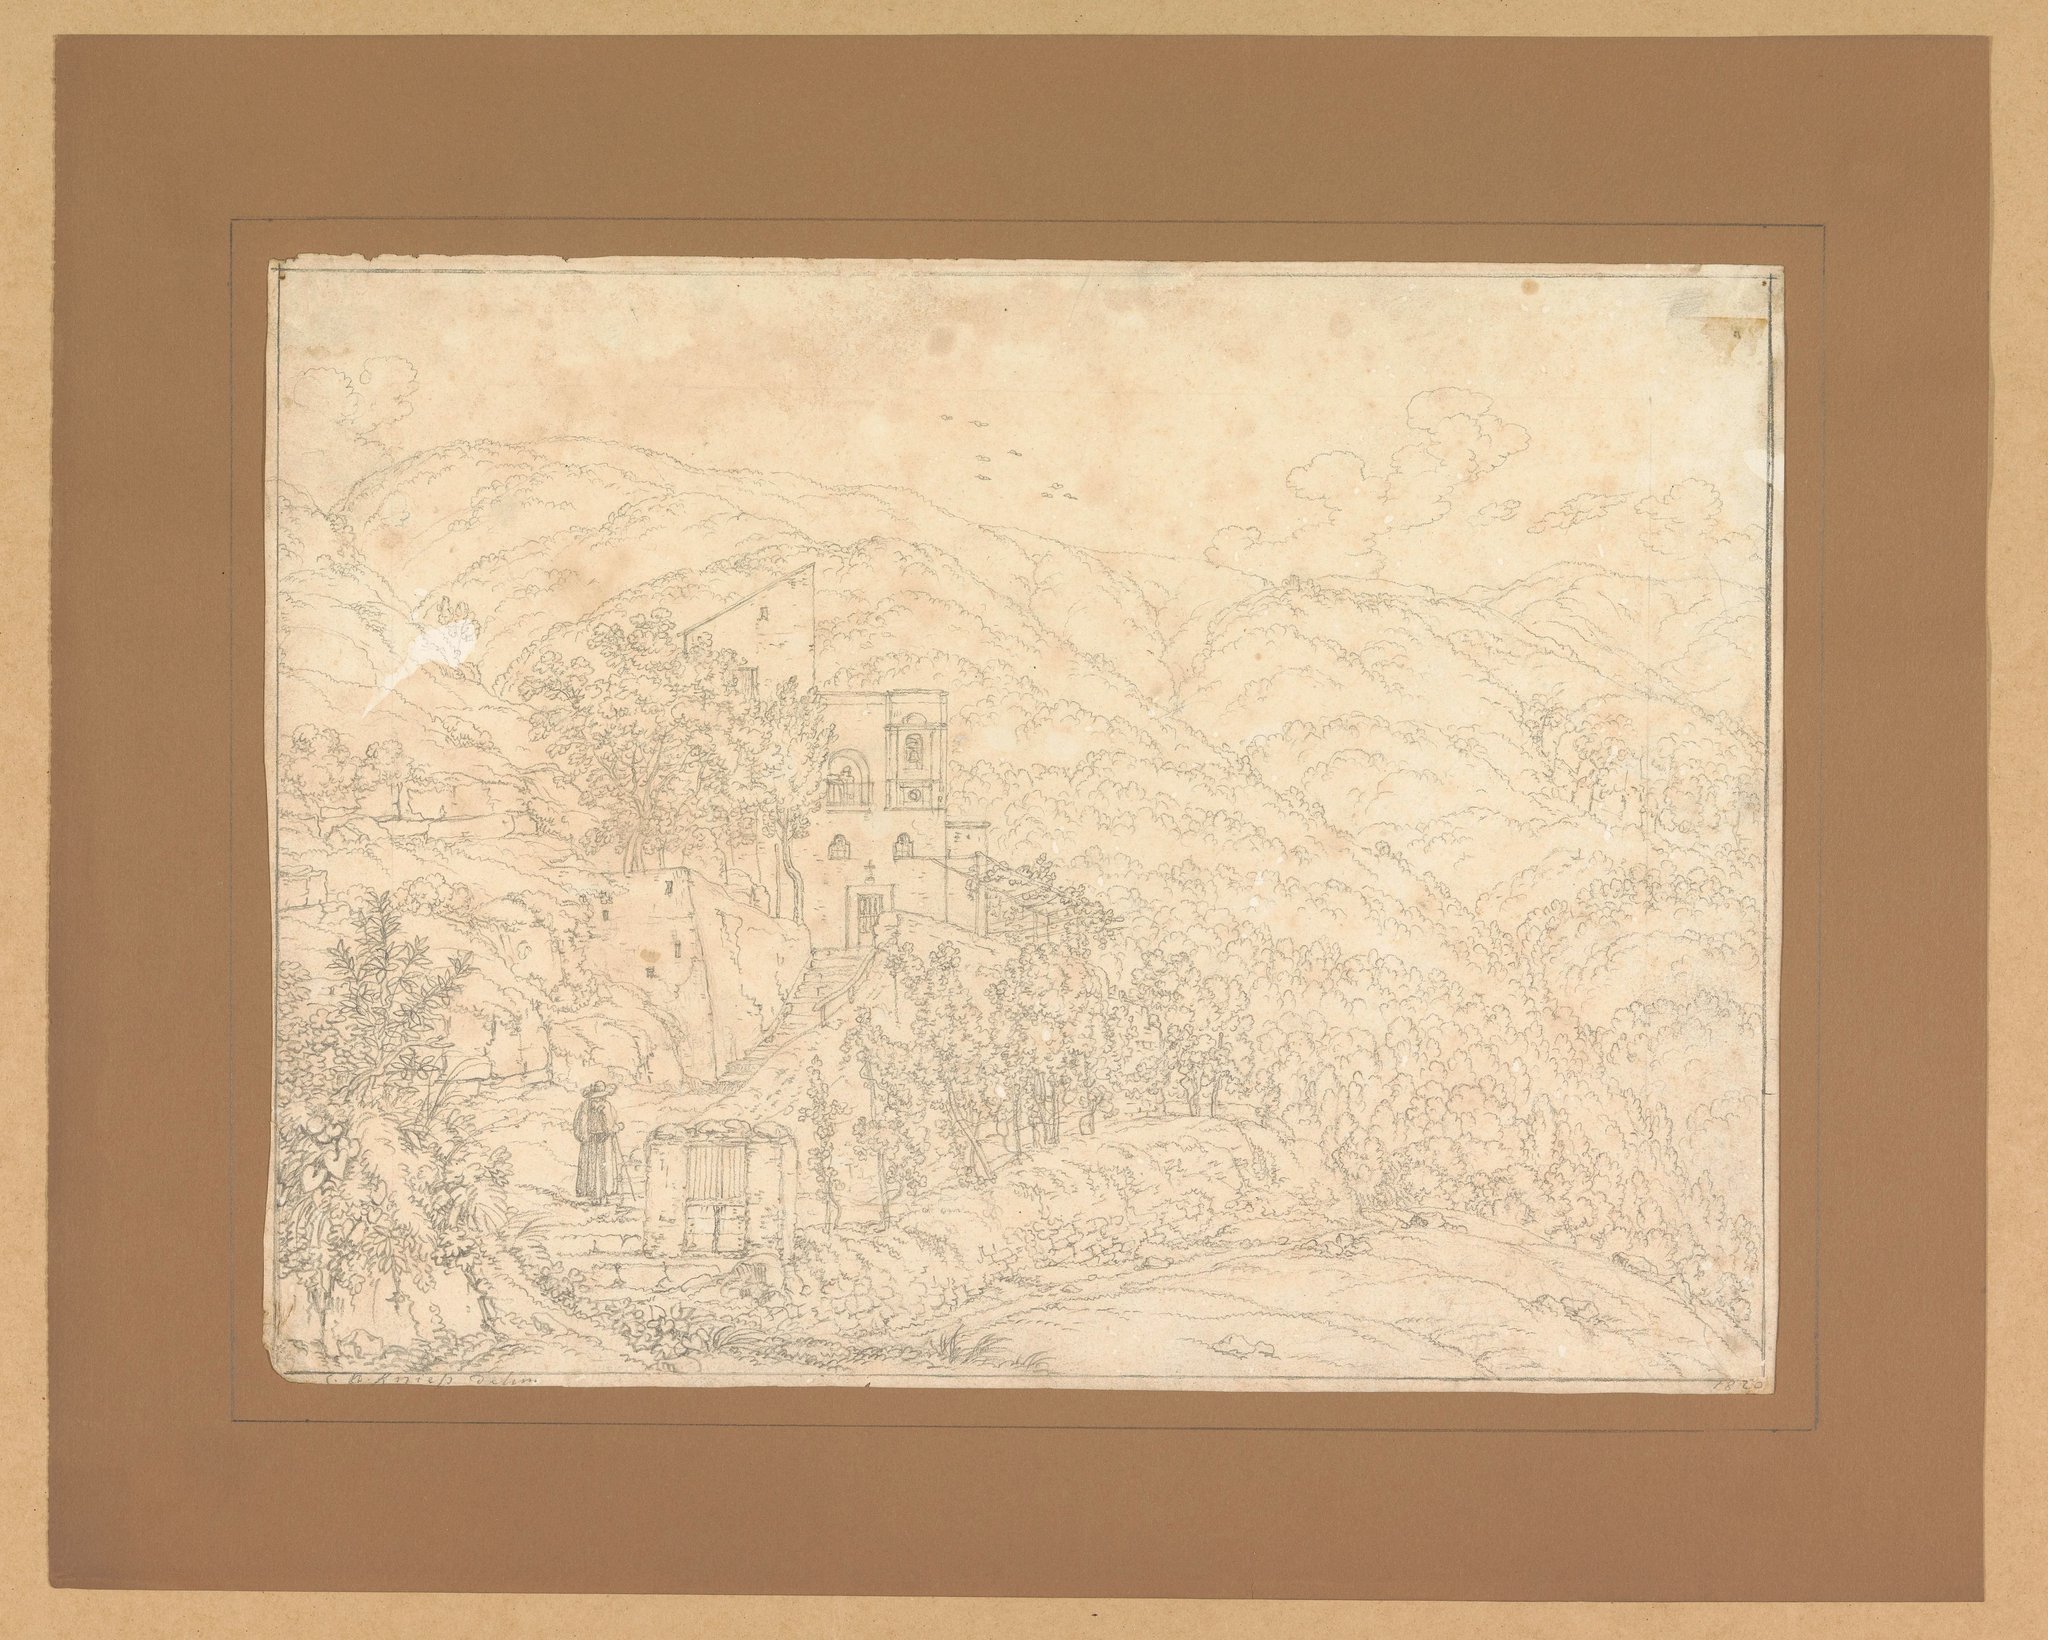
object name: drawing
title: Berglandschap met gebouw, met op de voorgrond een passant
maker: christoph heinrich kniep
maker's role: draughtsman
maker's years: 1755-1825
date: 1820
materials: paper, pencil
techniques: brush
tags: city-view, and landscape with man-made constructions, mountains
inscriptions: collector's mark: Lugt 2228